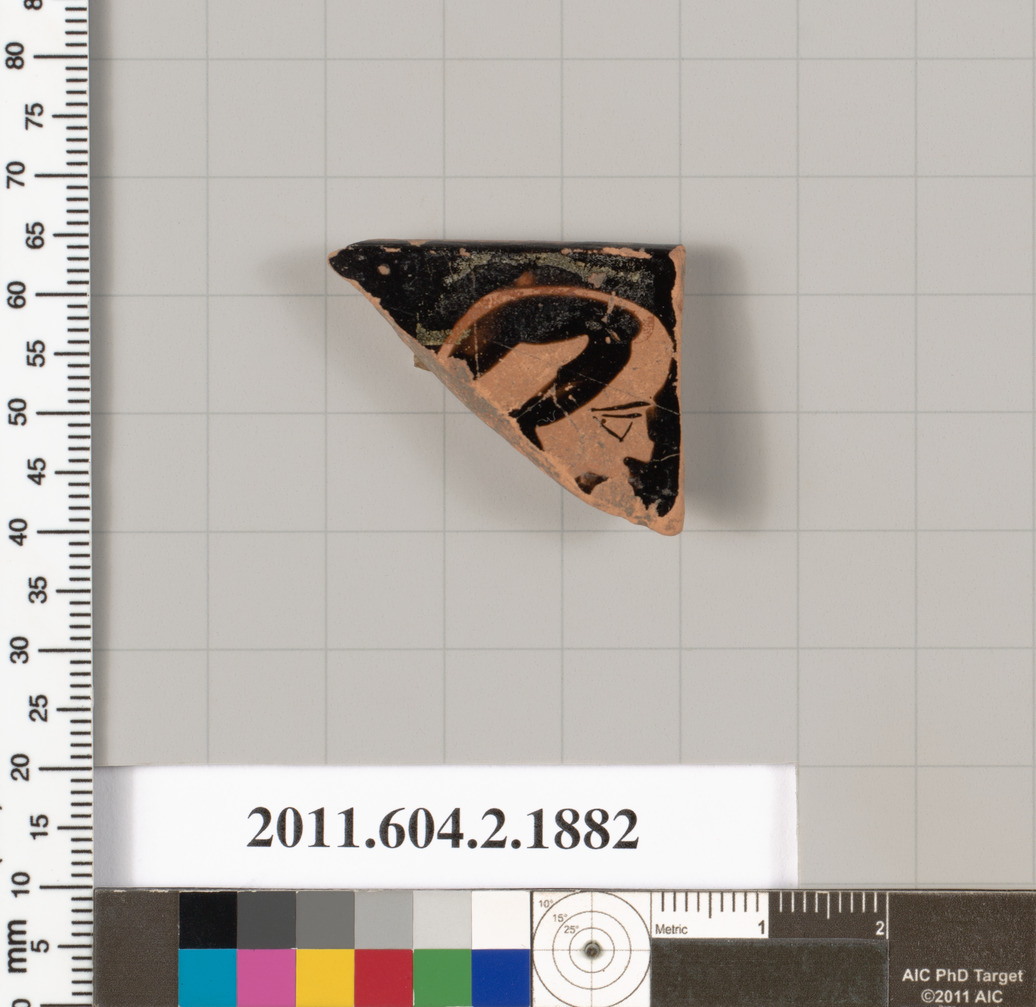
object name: skyphos fragment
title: Terracotta rim fragment of a skyphos (deep drinking cup)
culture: greek, attic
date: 425-401 BCE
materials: terracotta